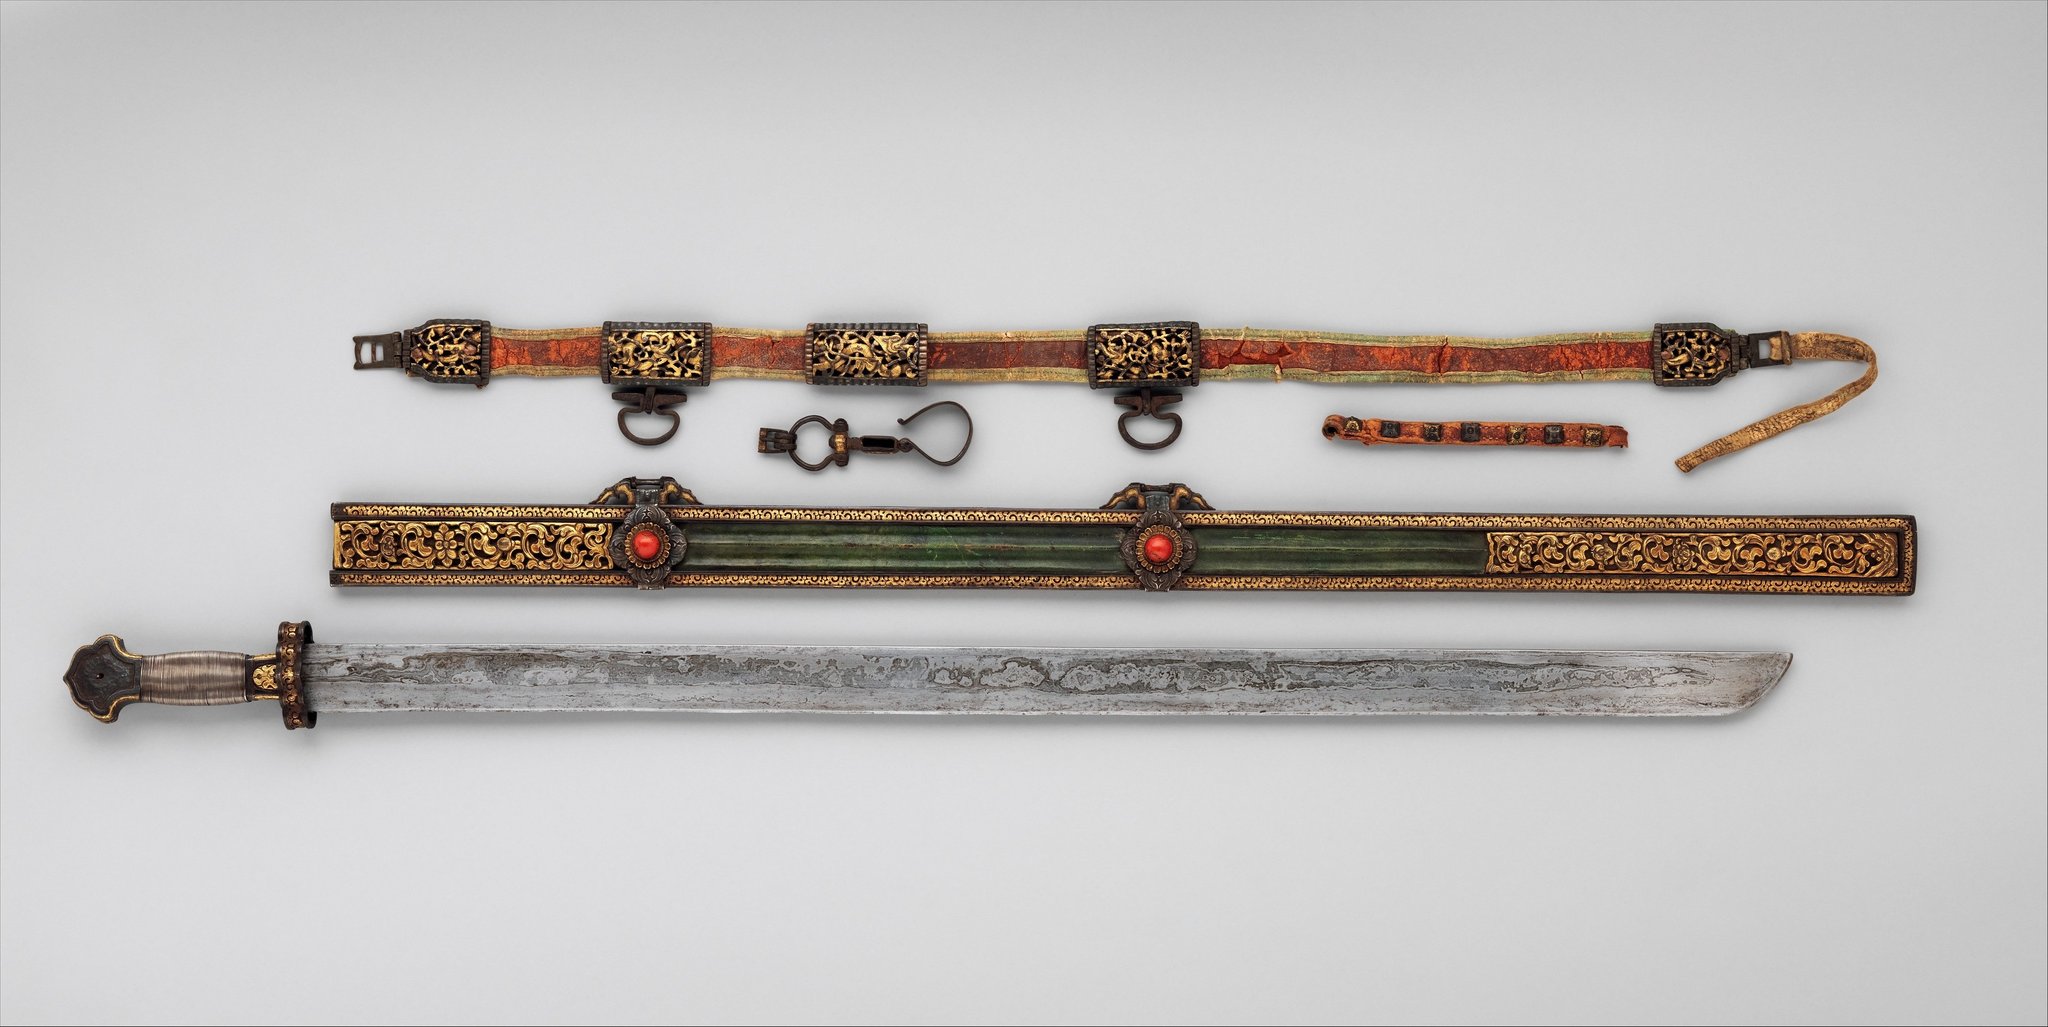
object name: sword belt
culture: tibetan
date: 1750-1850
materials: copper alloy, gold, iron, leather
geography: tibet